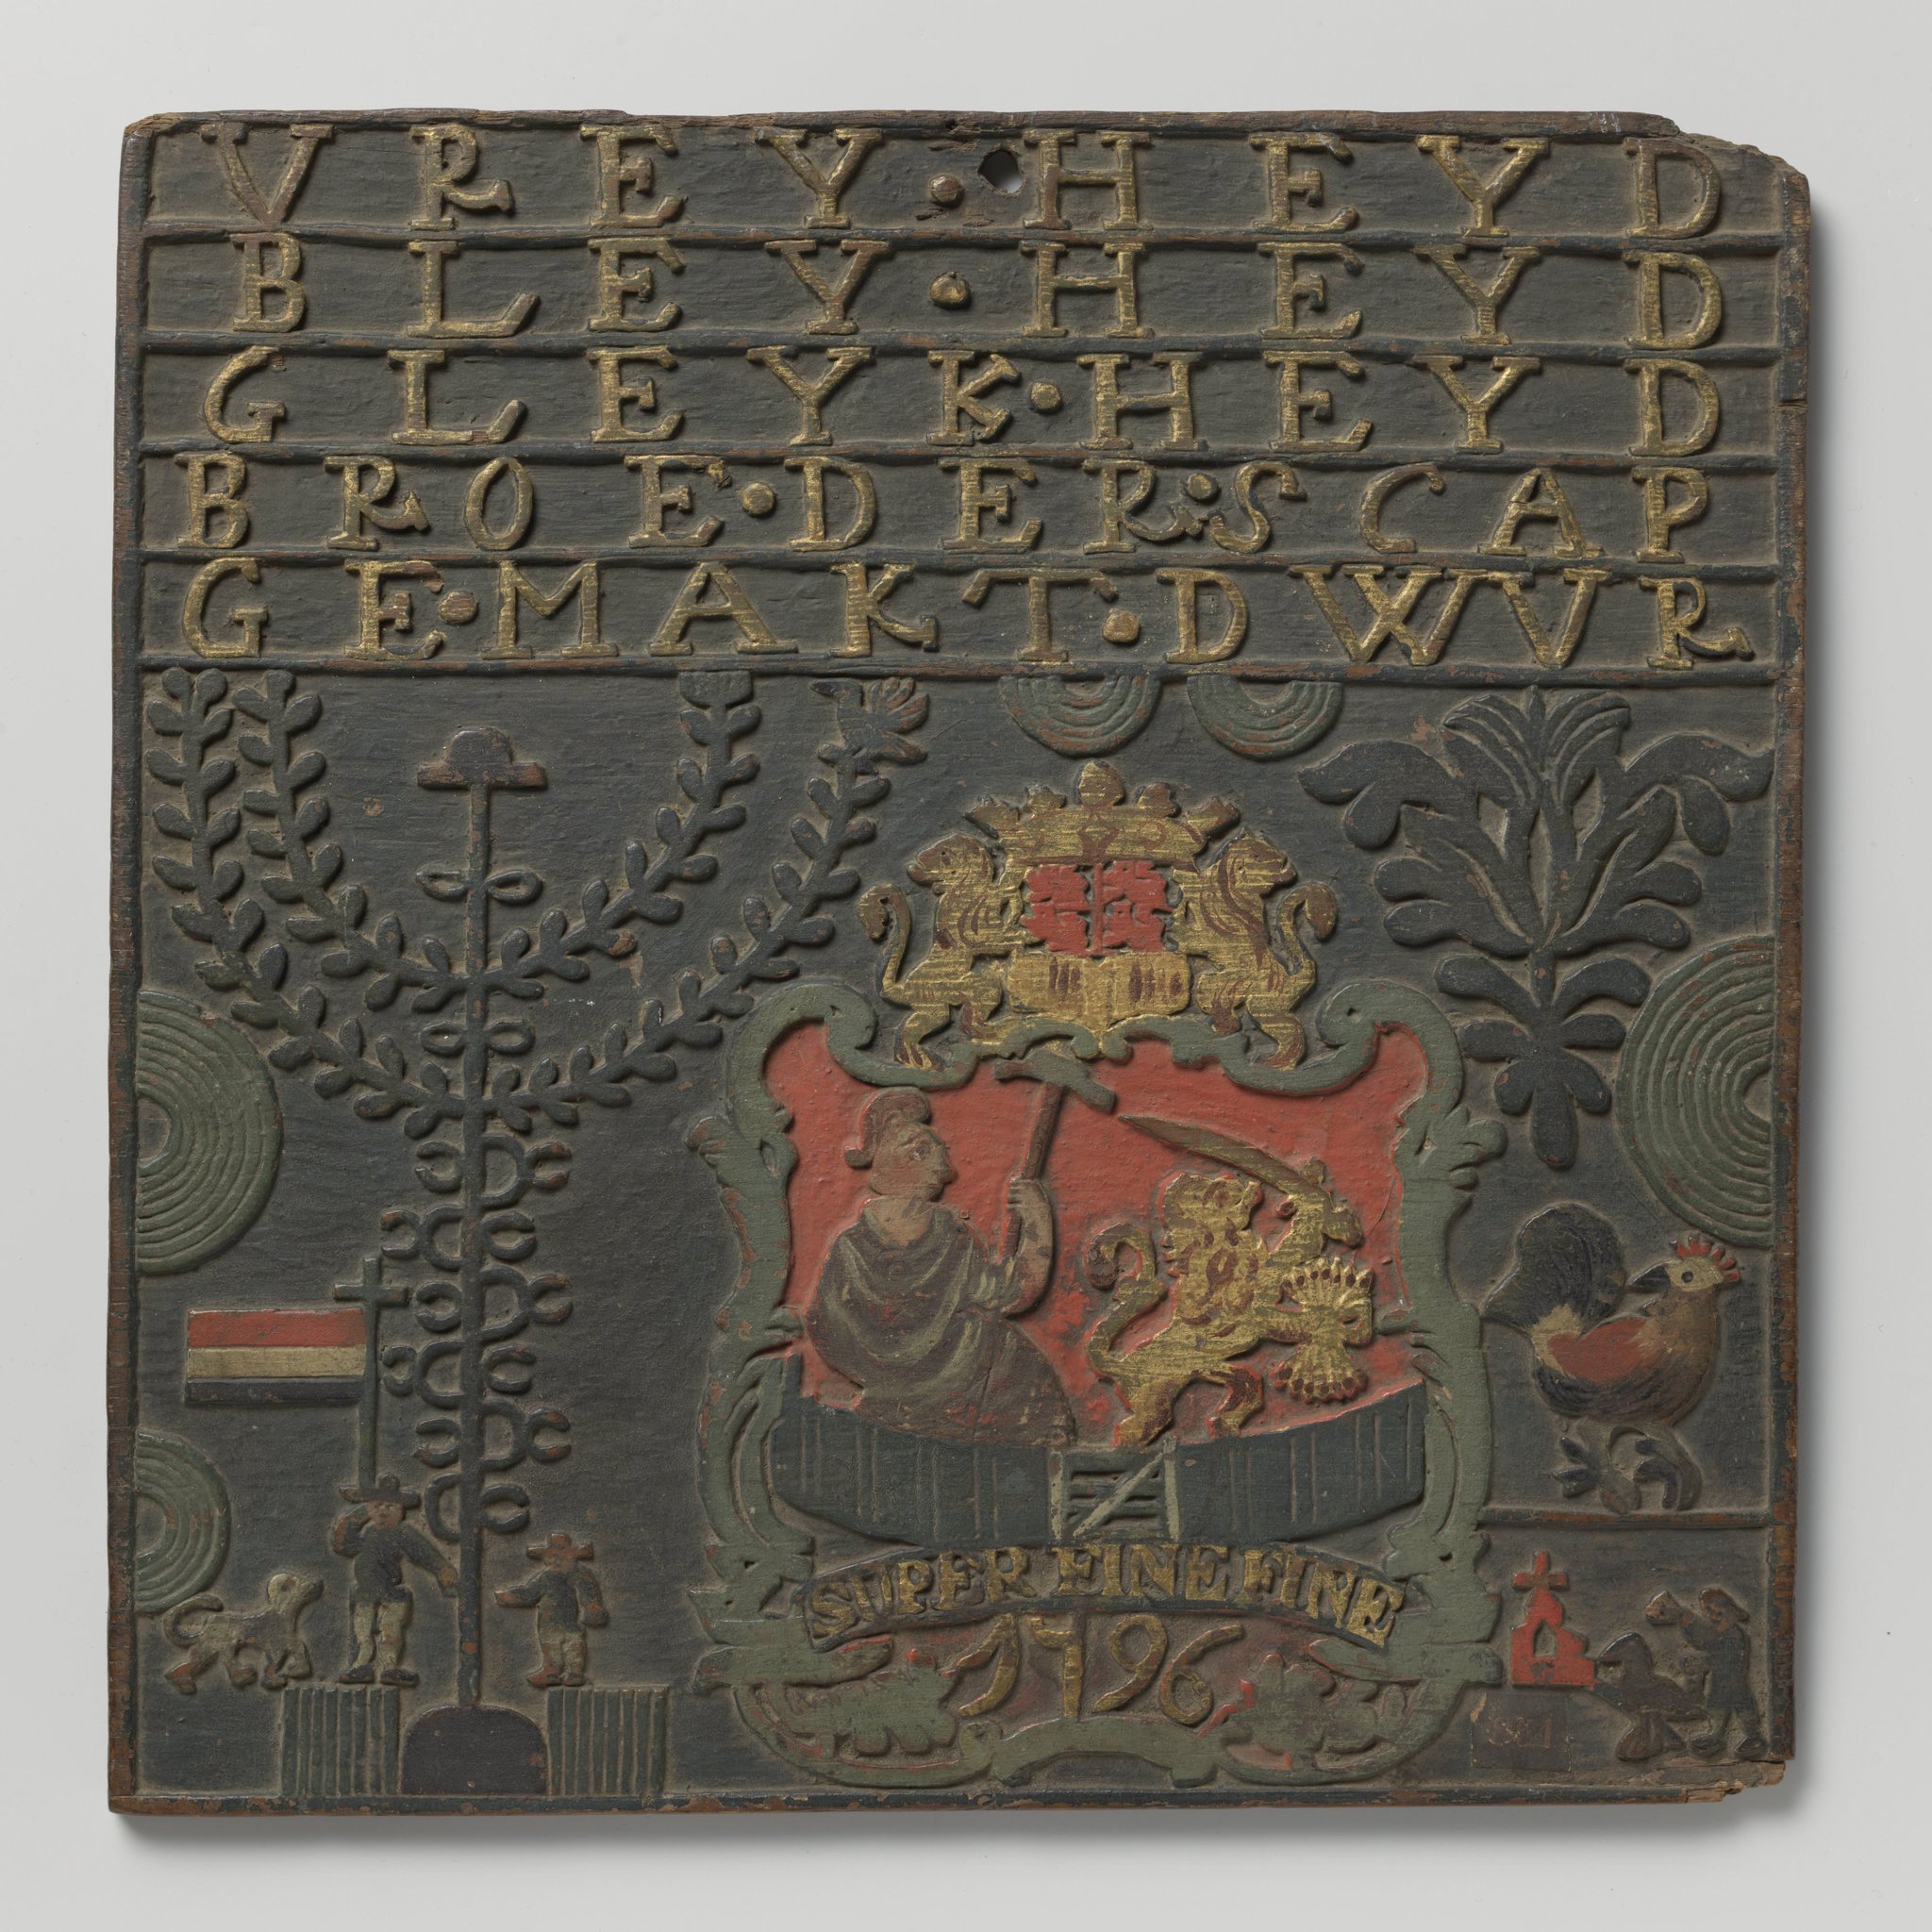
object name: uithangteken, uithangbord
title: Uithangbord met patriottische voorstelling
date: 1796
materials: paint, wood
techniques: gilding, polychromy, carving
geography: netherlands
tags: low countries, batavian republic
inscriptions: inscription: ‘SUPER FINE FINE’, inscription: ‘VREY.HEYD / BLEY.HEYD /GELEYK.HEYD / BROEDERSCAP / GE.MAKT.DWVR’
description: Houten gepolychromeerd vierkant plankje met voorstellingen en opschriften in plat reliëf. Onder opschrift vrijheid, blijheid etc. Voorstelling v.l.n.r. hond, man met driekleur naast vrijheidsboom, de Hollandse maagd met staf en hoed, leeuw met zwaard en pijlenbundel en meer.